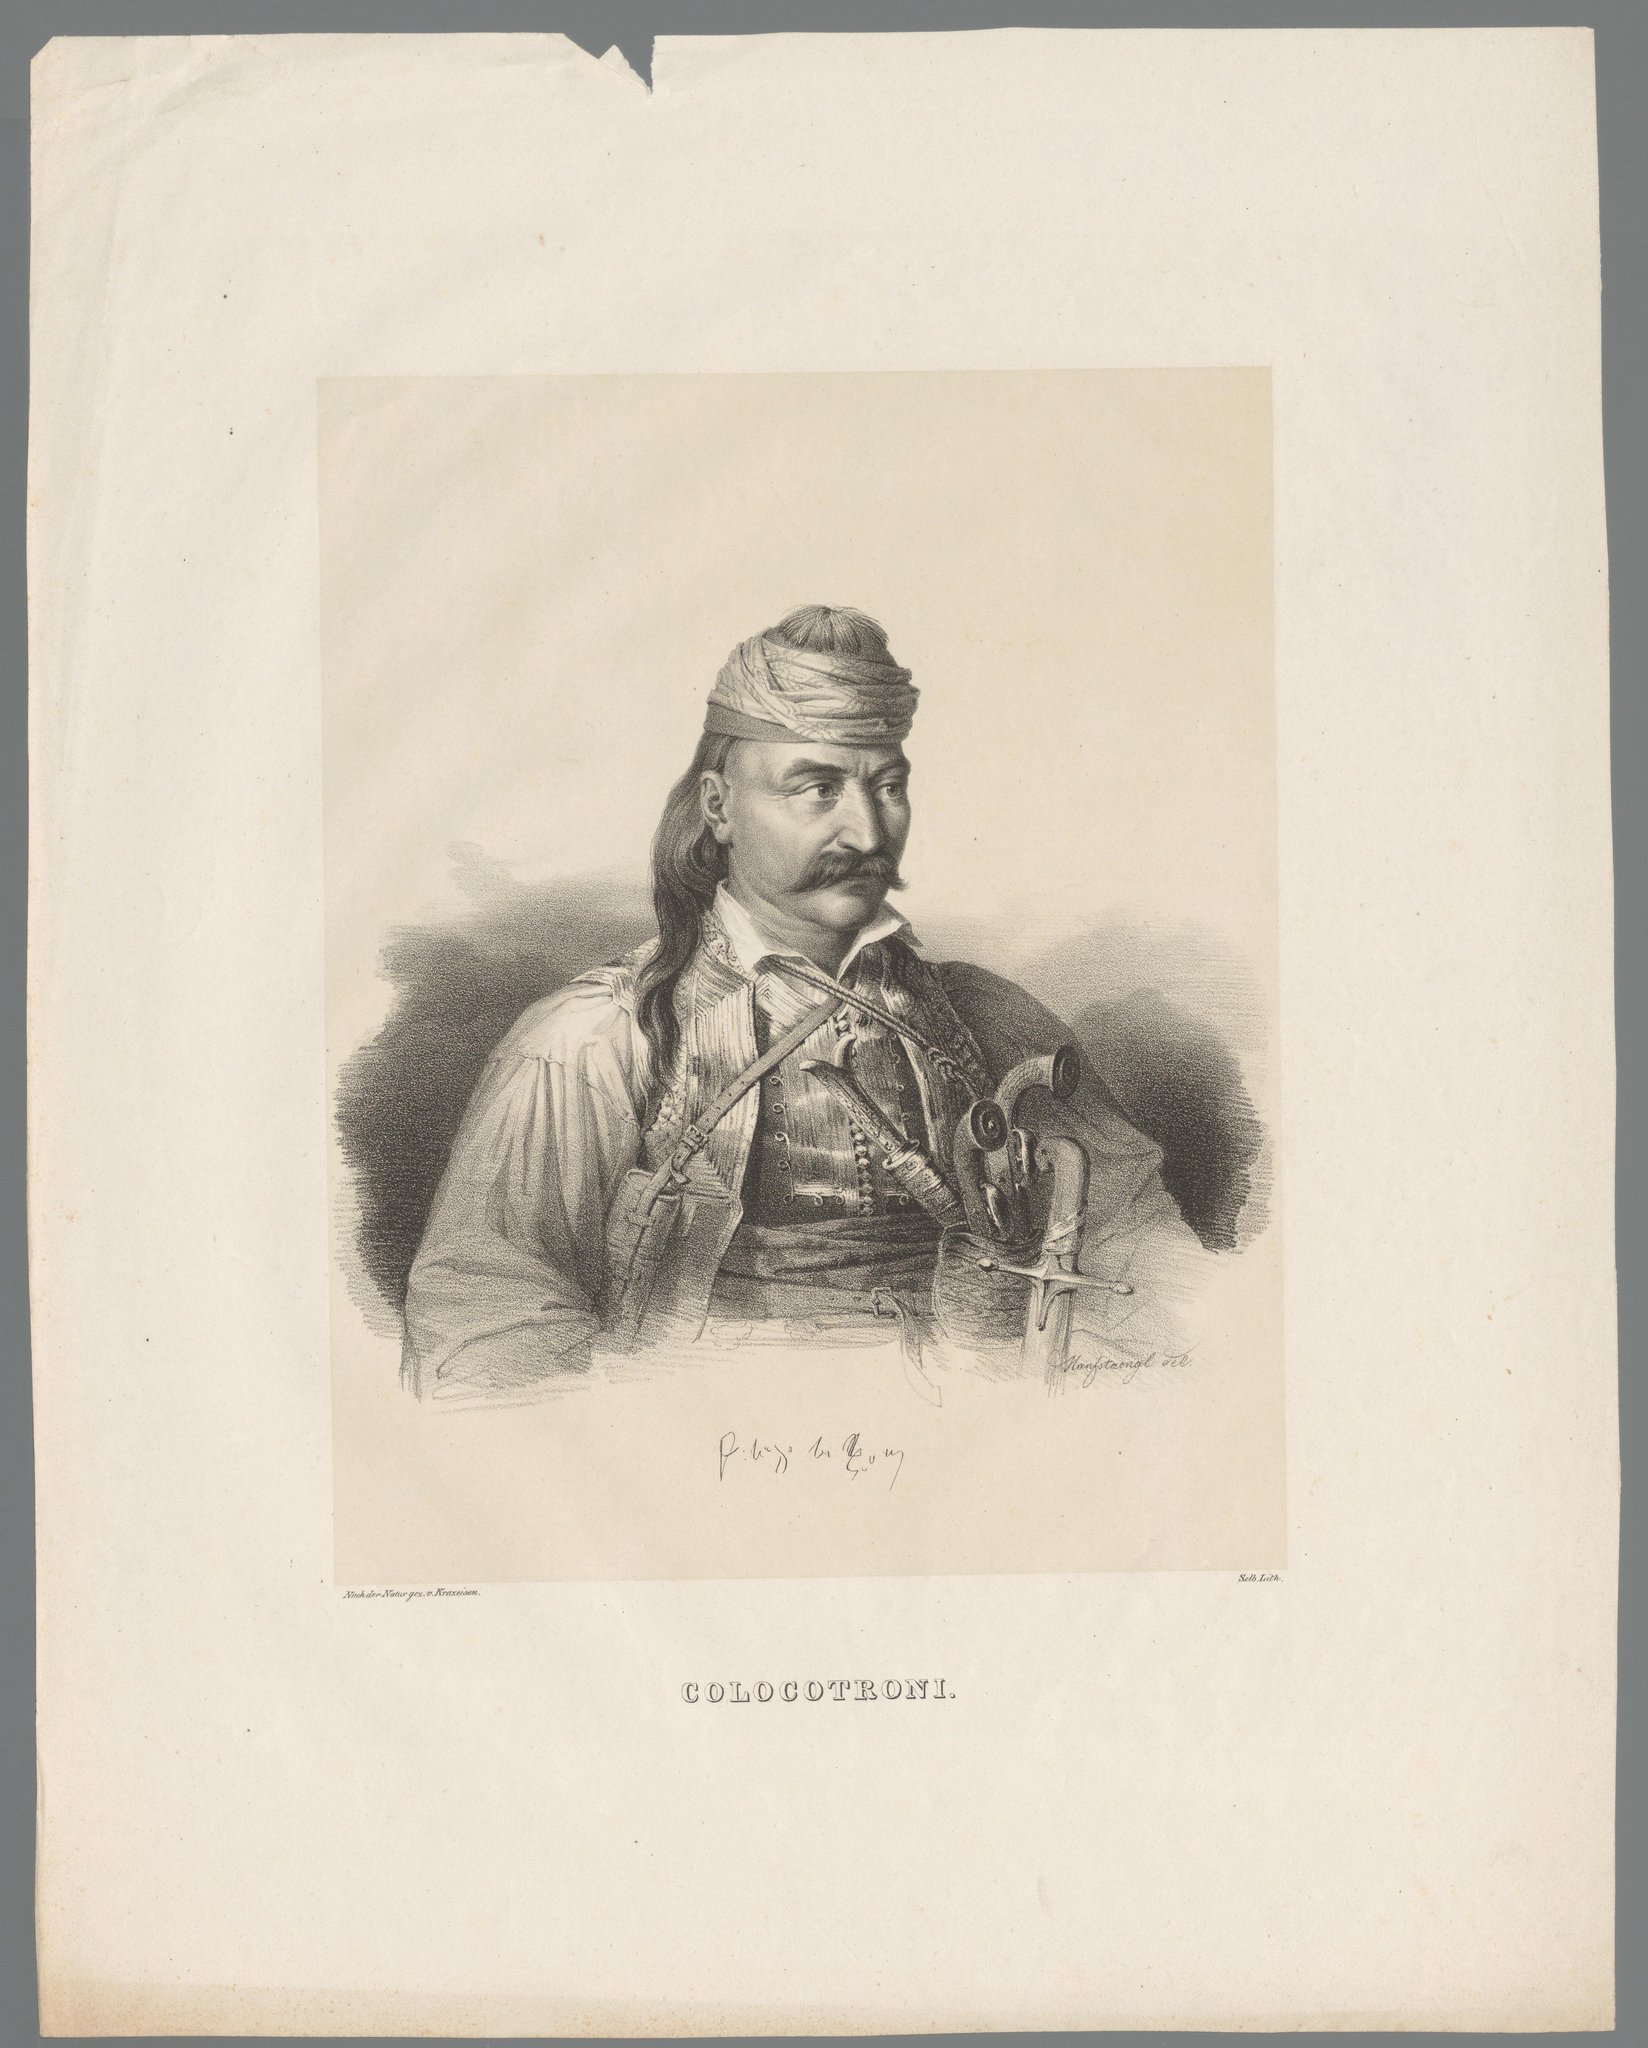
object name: print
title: Portret van Theodoros Kolokotronis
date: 1828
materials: paper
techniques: tone lithography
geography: munich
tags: adult man, historical persons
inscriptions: collector's mark: Lugt 2228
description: De prent hoort mogelijk bij een serie prenten met portretten van betrokkenen bij de Griekse onafhankelijkheidsoorlog. Mogelijk de serie: Bildnisse ausgezeichneter Greichen und Philhellene nebst einigen Ansichten und Trachten.